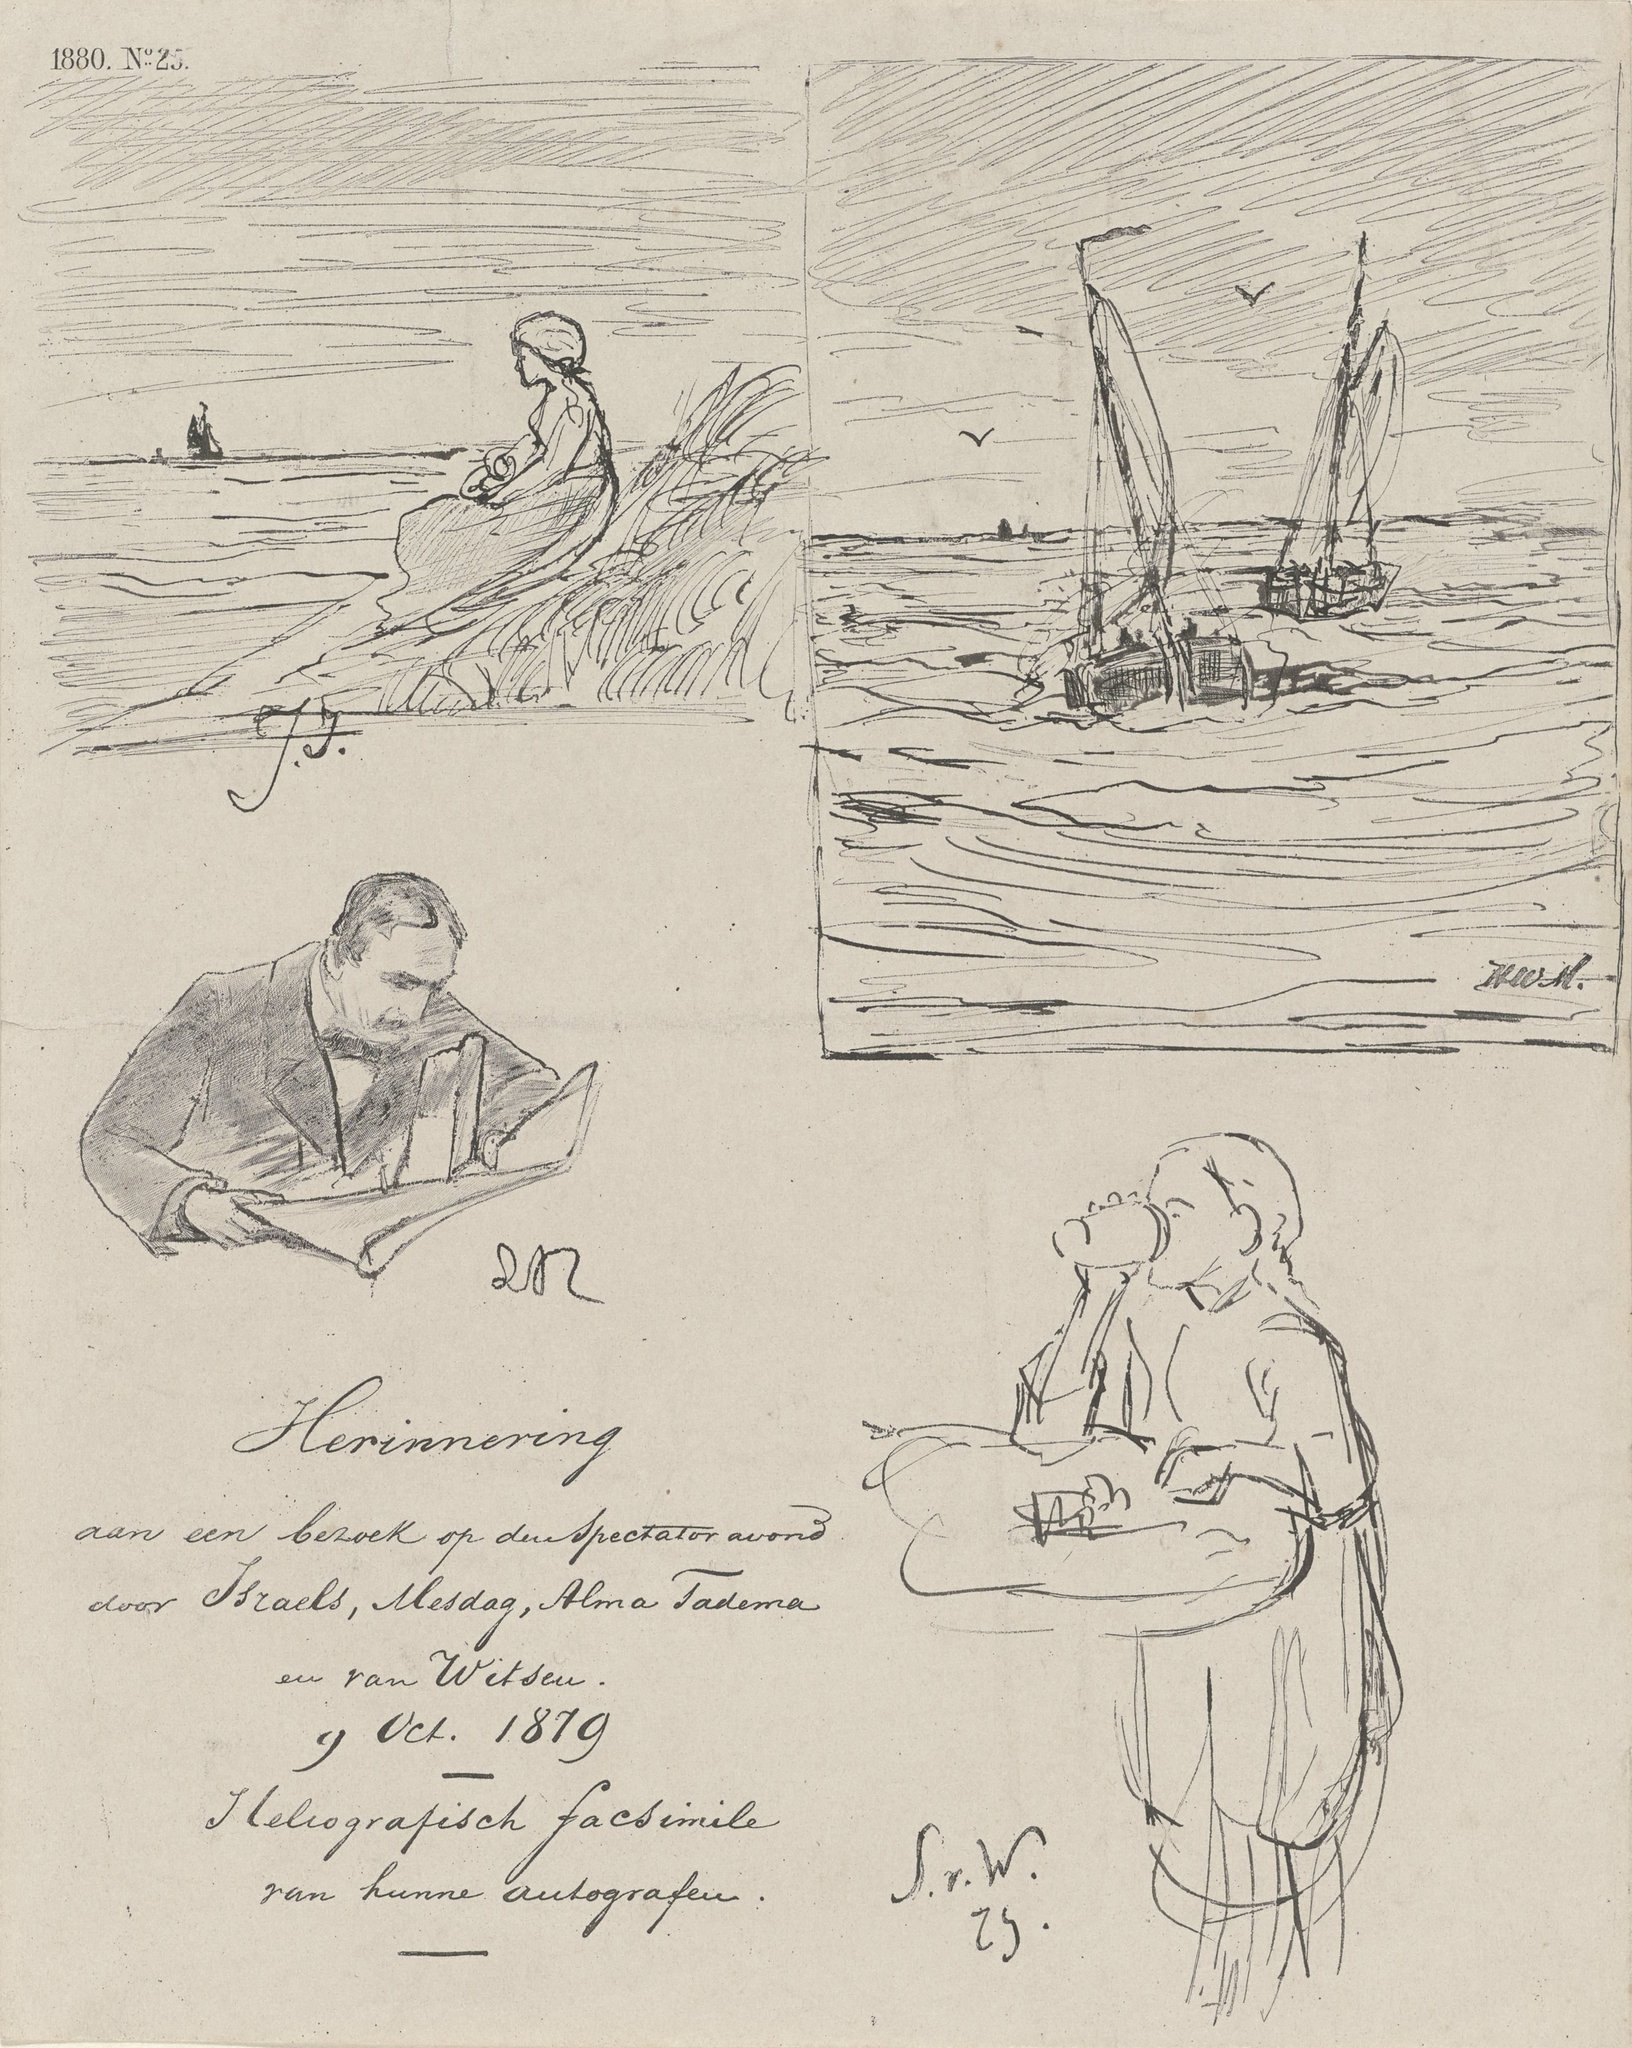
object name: print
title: Herinnering aan een bezoek op de Spectator avond door Israels, Mesdag, Alma Tadema en van Witsen. 9 Oct. 1879 / Heliografisch facsimile van hunne autografen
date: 1879-1880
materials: paper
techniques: photoaquatint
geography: netherlands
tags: drawing, sketch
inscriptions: collector's mark: Lugt 2228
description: Blad met vier afzonderlijke schetsen van: een meisje zittend aan de waterkant (Israëls), twee boten op het water (Mesdag), een lezende man (Alma Tadema) en een drinkend meisje (Van Witsen). Reproductie naar schetsen gemaakt op 9 oktober 1879 tijdens een bezoek aan De Nederlandsche Spectator.